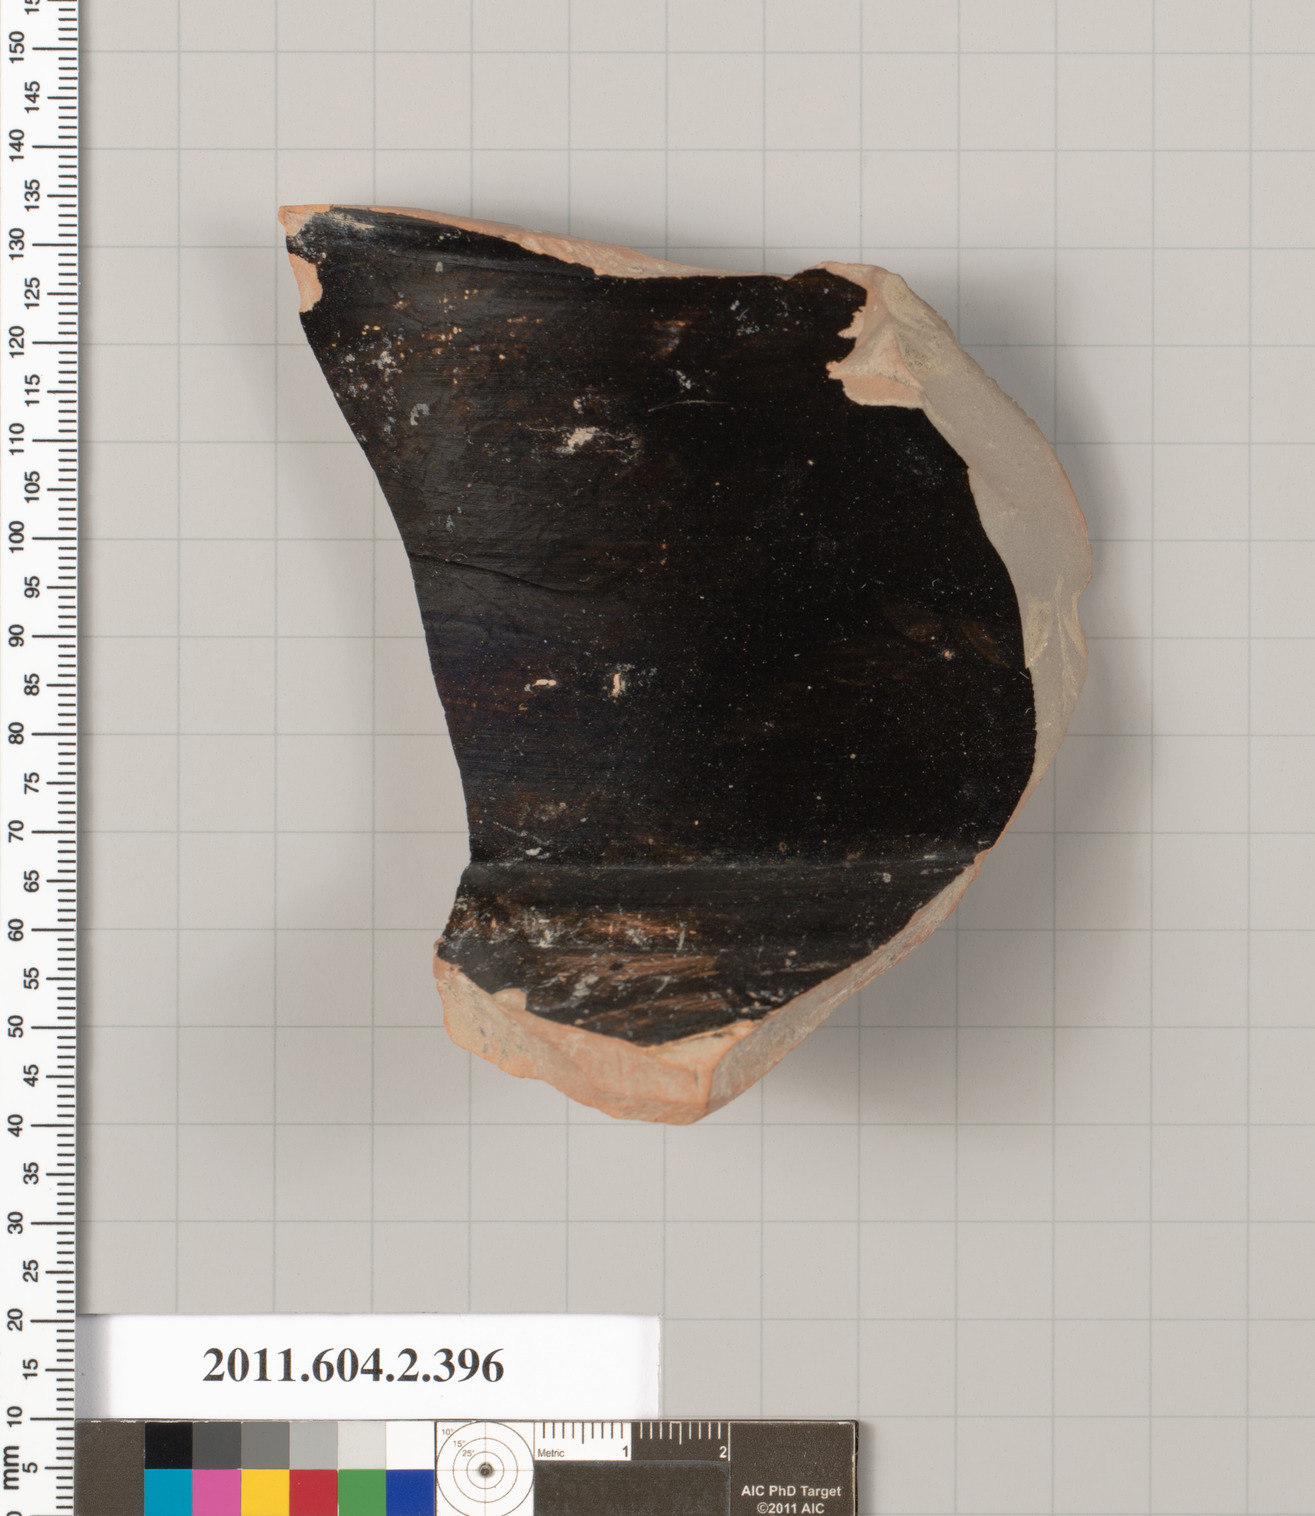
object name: column krater fragment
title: Terracotta fragment of a column-krater (bowl for mixing wine and water)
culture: greek, attic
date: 475-451 BCE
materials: terracotta